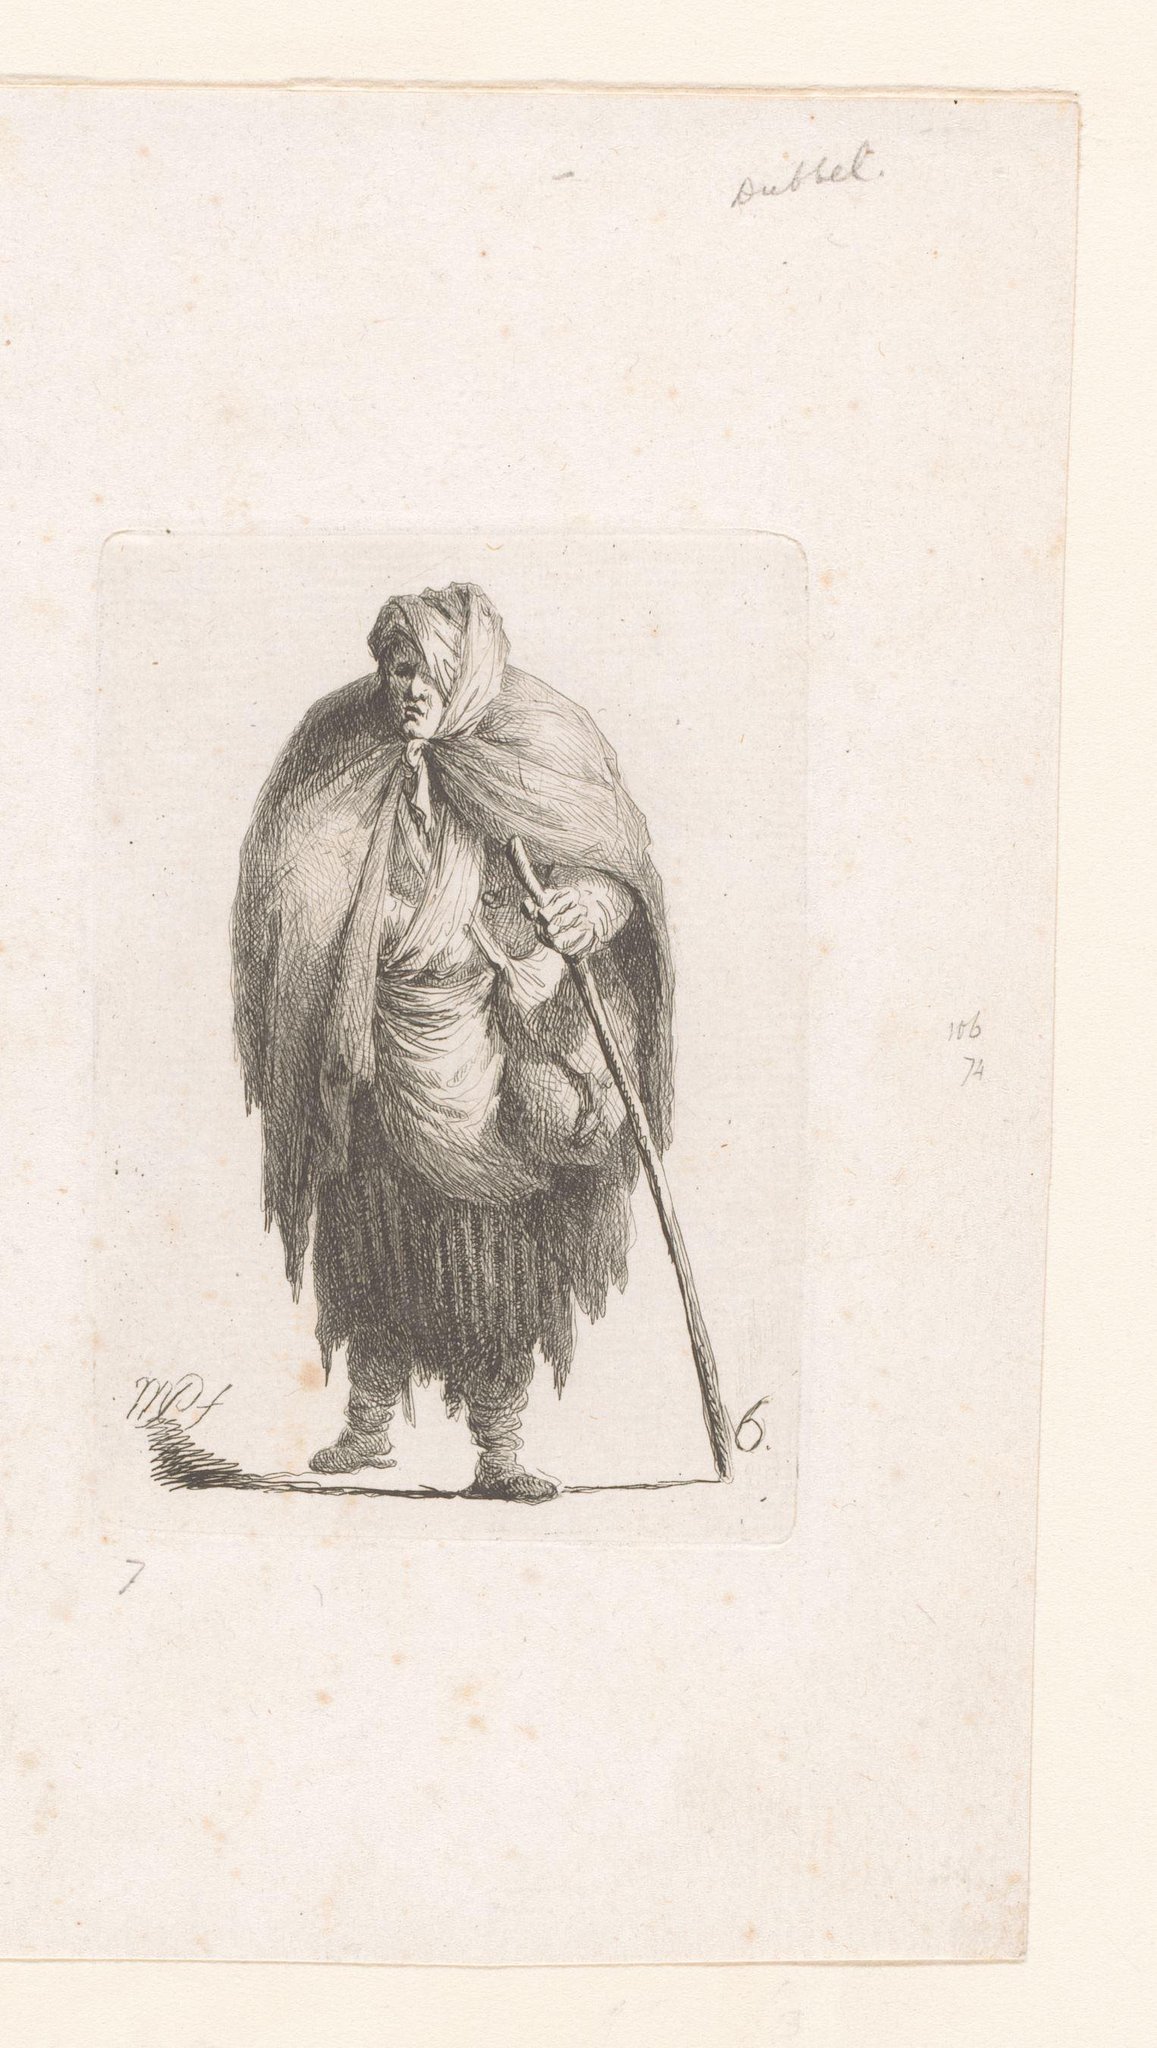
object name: print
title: Landloper met een staf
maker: michał płoński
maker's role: print maker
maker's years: 1778-1812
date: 1802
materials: paper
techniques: etching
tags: 'fahrende leute', vagrants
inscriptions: collector's mark: Lugt 2228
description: Op één blad met RP-P-1885-A-8761 en RP-P-1885-A-8762.